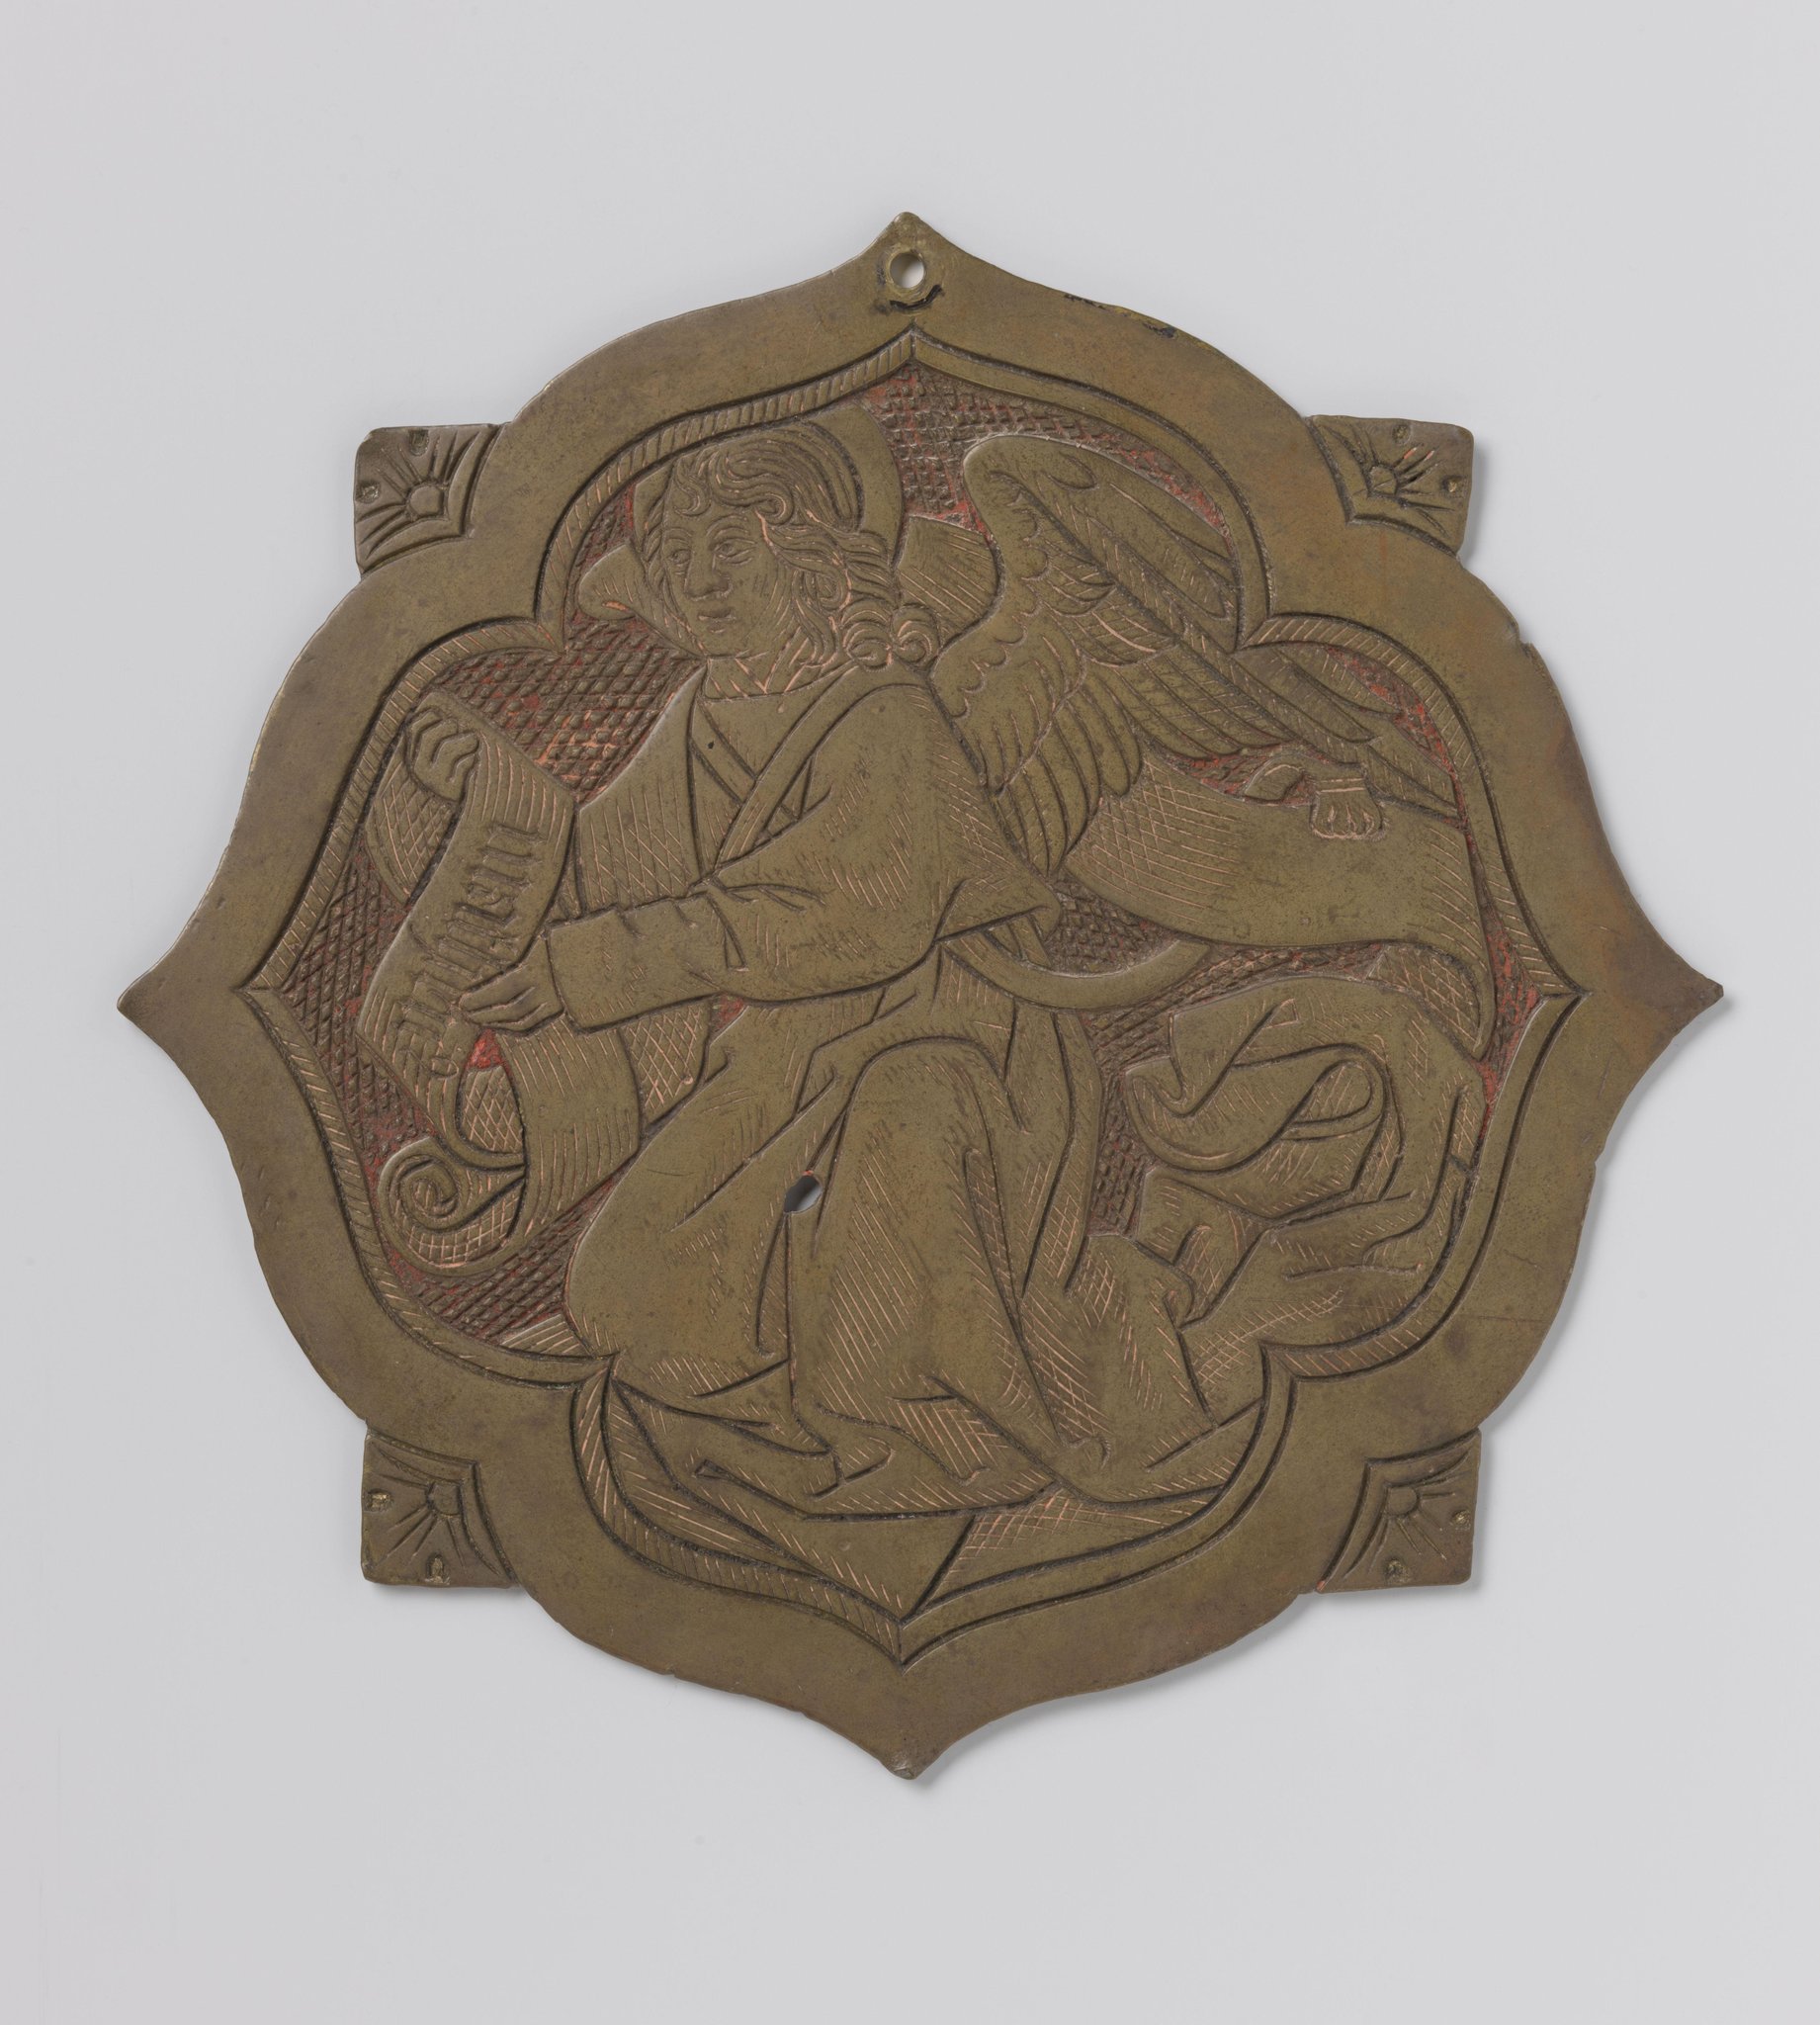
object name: plate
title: Corner Plates of the Tombstone of Gijsbert Willemsz Raet, with the Four Evangelists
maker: Anonymous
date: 1511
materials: brass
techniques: casting, cutting, engraving, gilding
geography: low countries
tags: the apostle and evangelist matthew (mattheus); possible attributes: angel, axe, book, halberd, pen and inkhorn, purse, scroll, square, sword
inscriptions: inscription, on the banderole, inscised: ‘matheus’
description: These four corner plates feature the symbols of the Four Evangelists: a winged lion (Mark), a winged ox (Luke), an eagle (John) and an angel (Matthew). The influence of printmaking – and specifically of Martin Schongauer – on other art forms is clear to see here. Slight differences notwithstanding, the maker was certainly inspired by either Schongauer’s engravings or copies thereof, or objects based on those prints.